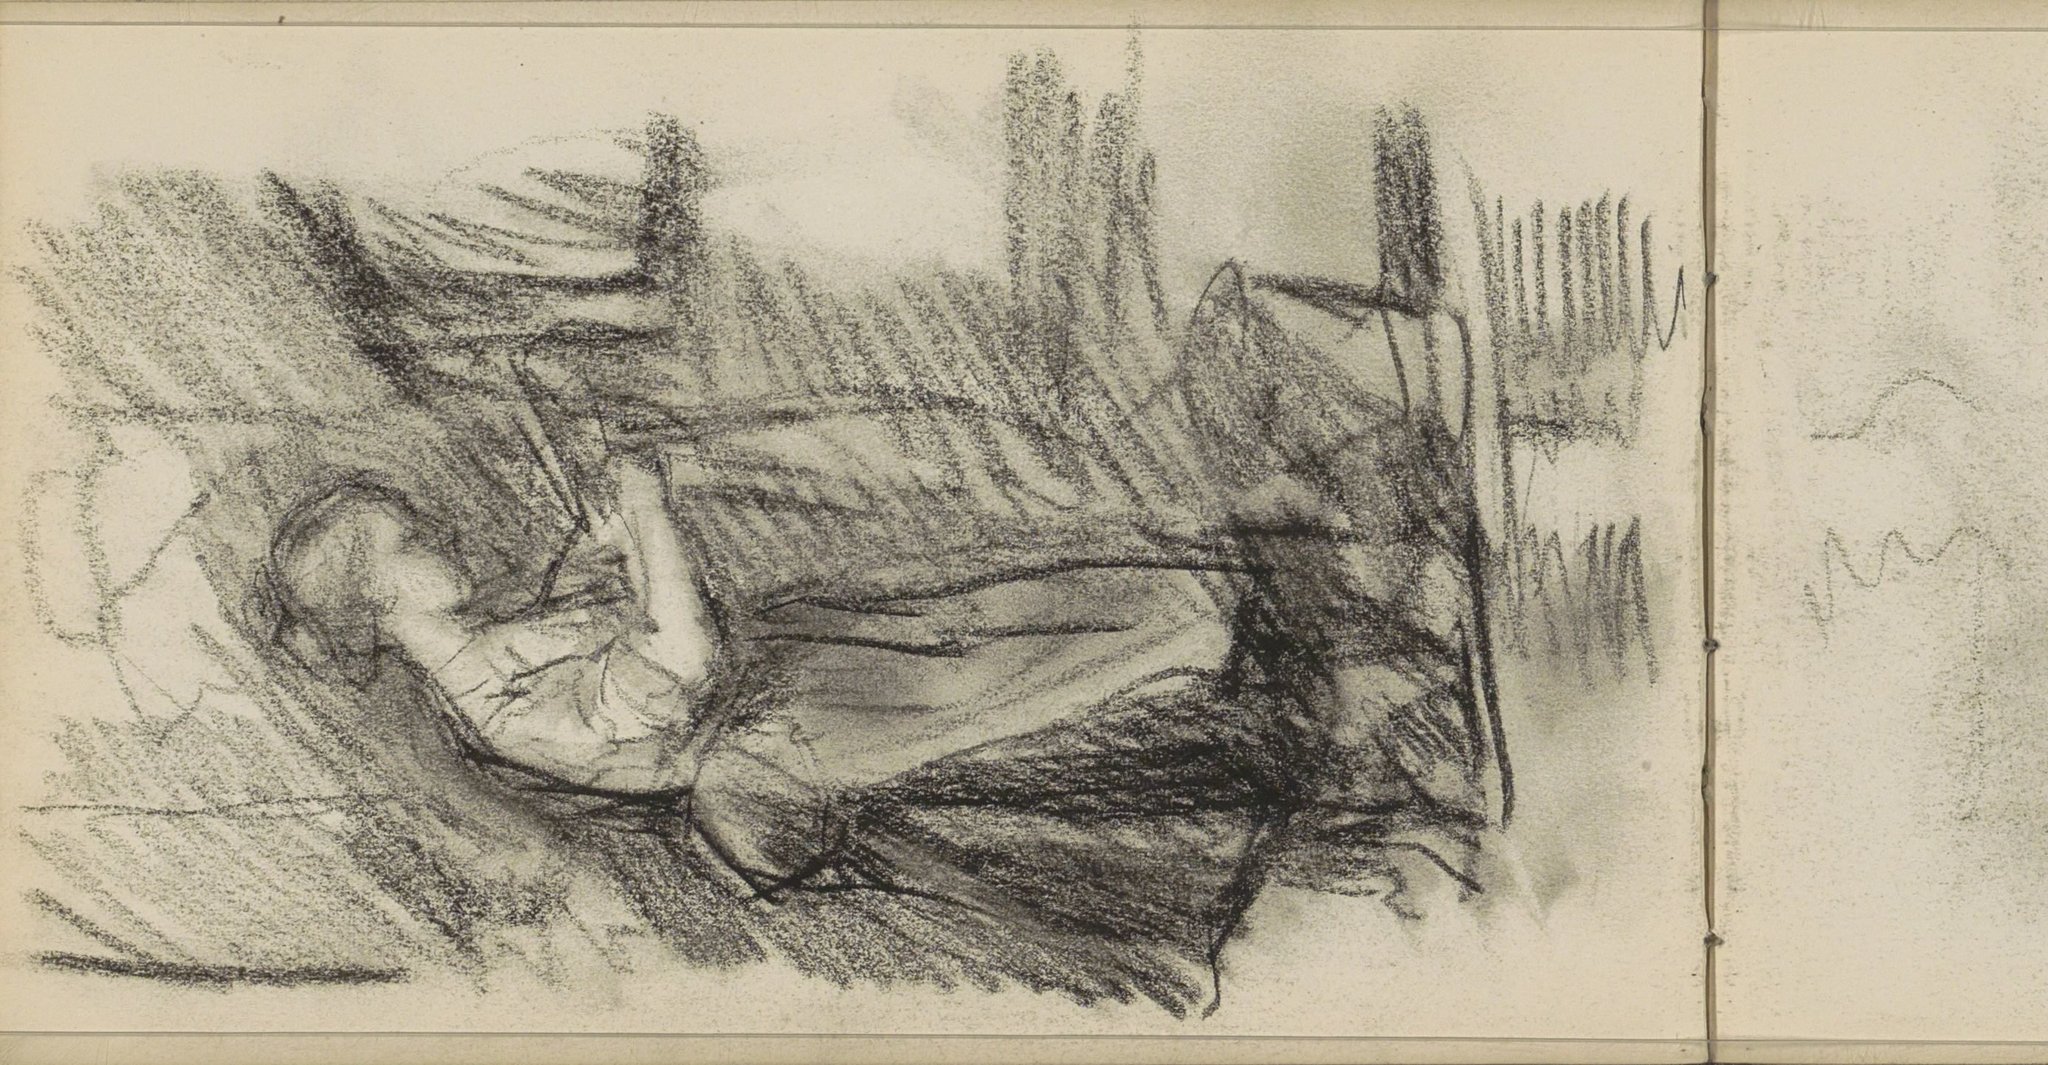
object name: sketchbook leaf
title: Jonge vrouw met een emmer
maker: johan antonie de jonge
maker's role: draughtsman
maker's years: 1864-1927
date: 1901-1927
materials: chalk, paper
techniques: stumping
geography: south holland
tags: adolescent, young woman, maiden, writing accessories, container of metal: bucket, can, canister, drum, tin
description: Een jonge vrouw staat achter een emmer. Ze heeft mogelijk schrijfgerei in haar hand. Blad 17 verso uit een schetsboek met 45 bladen.